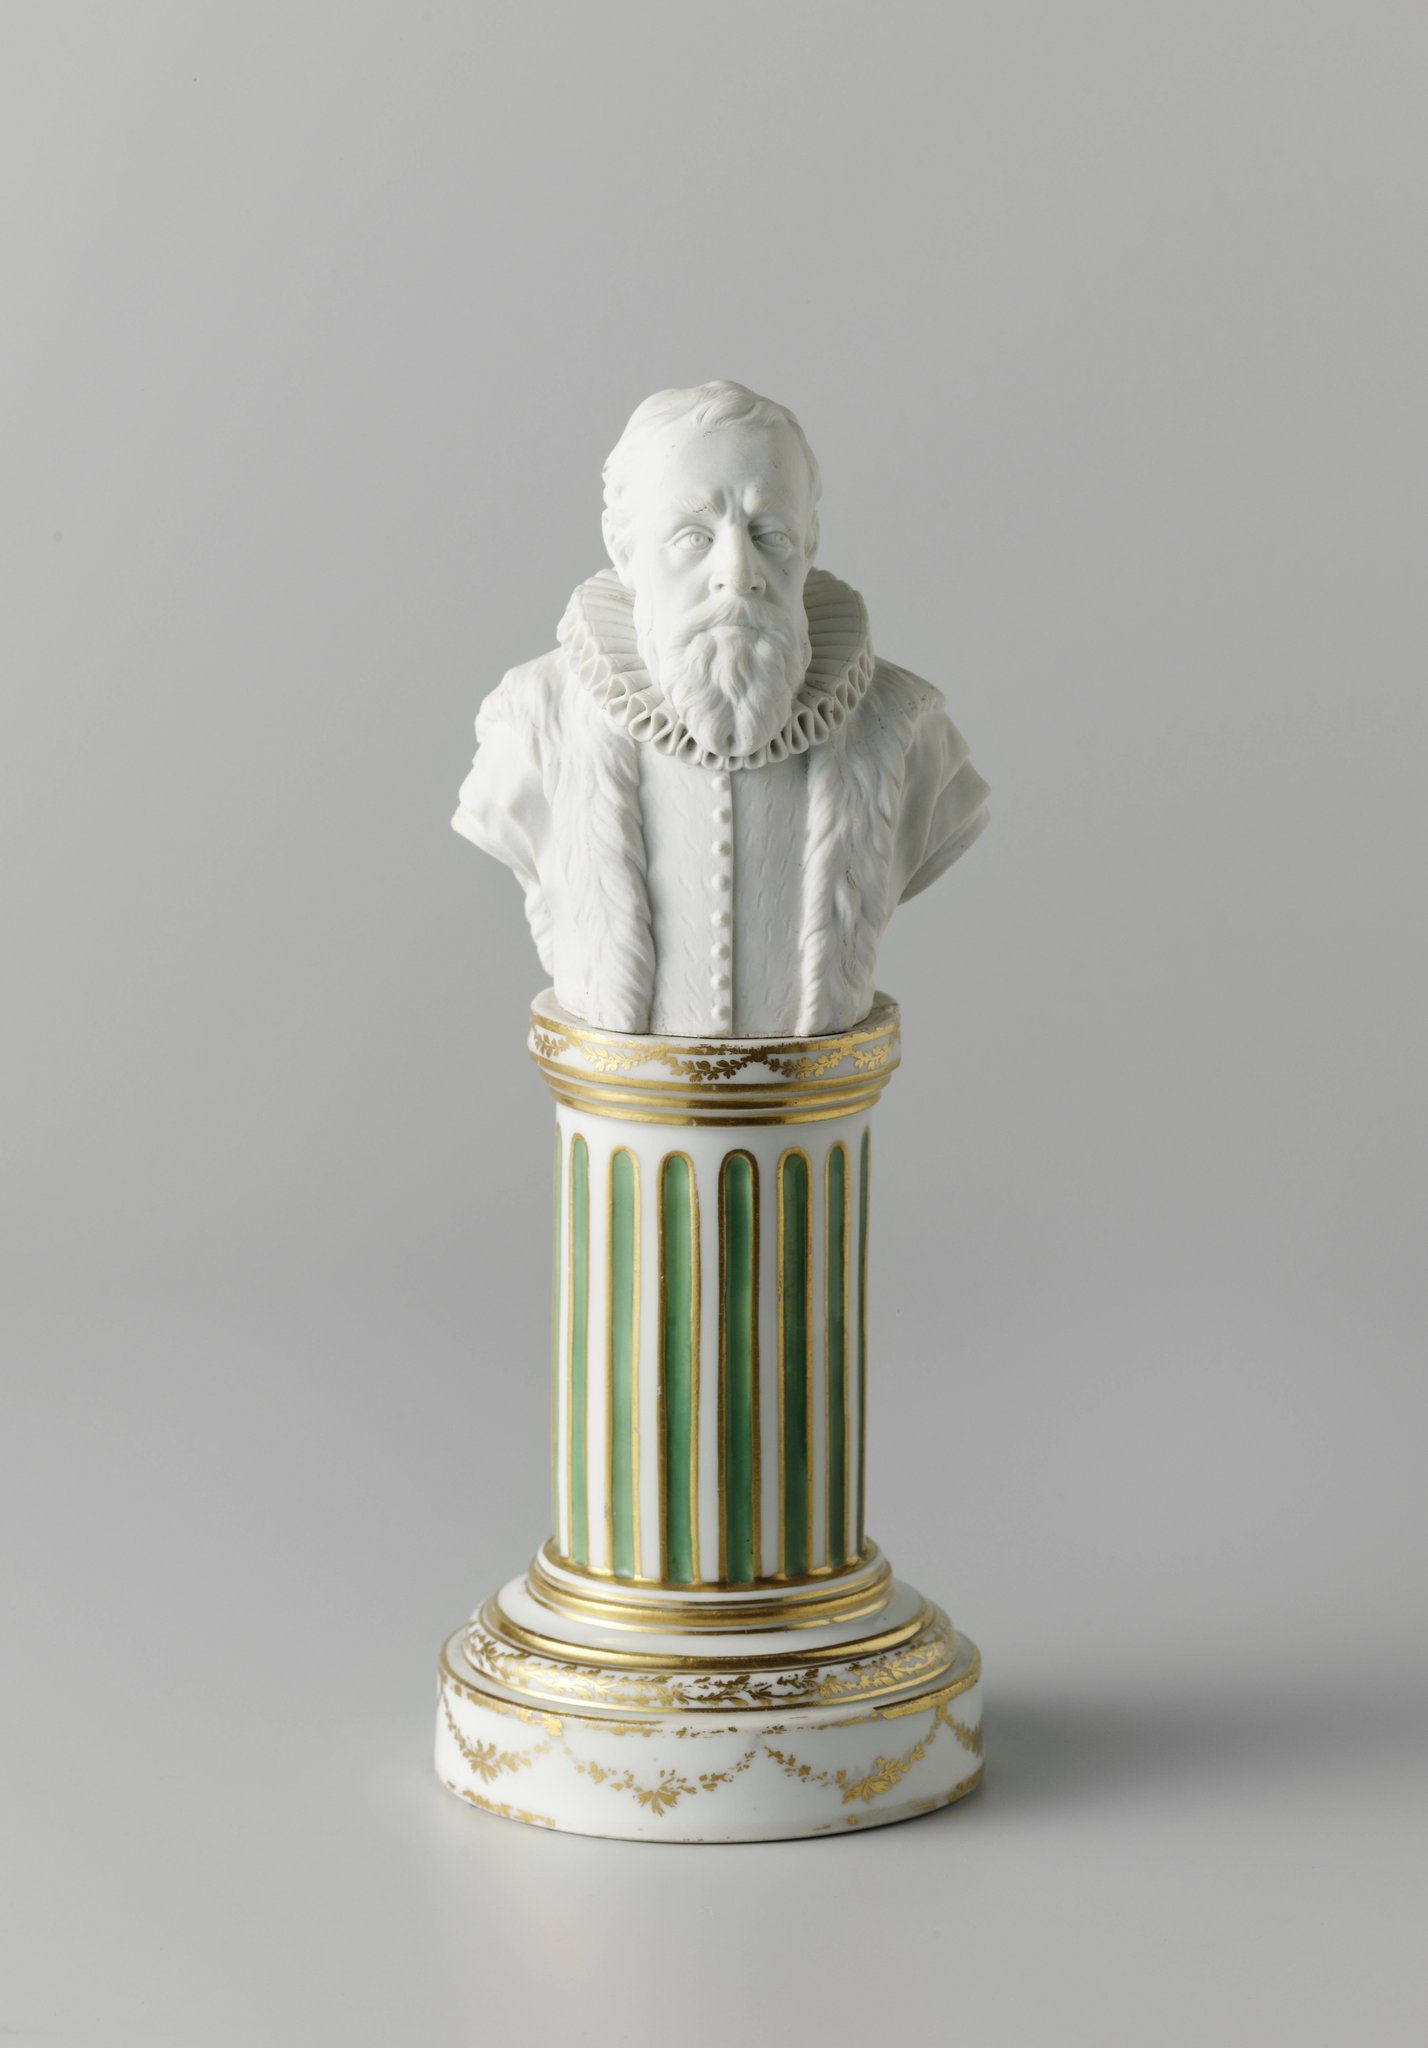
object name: bust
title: Johan van Oldenbarnevelt (1547-1619)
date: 1782-1784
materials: biscuit porcelain, material), porcelain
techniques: biscuit (porcelain, material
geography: loosdrecht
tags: the hague, johan van oldenbarnevelt, historical persons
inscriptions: factory mark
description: Porcelain from the factory at Loosdrecht. Bust of Johan van Oldenbarneveld (1547 - 1619) on pedestal. Biscuit porcelain, c. 1782 - 1784. Factory under direction of Friedrich Daeuber. The bust after a print by J. Houbraken after A. Schouman.